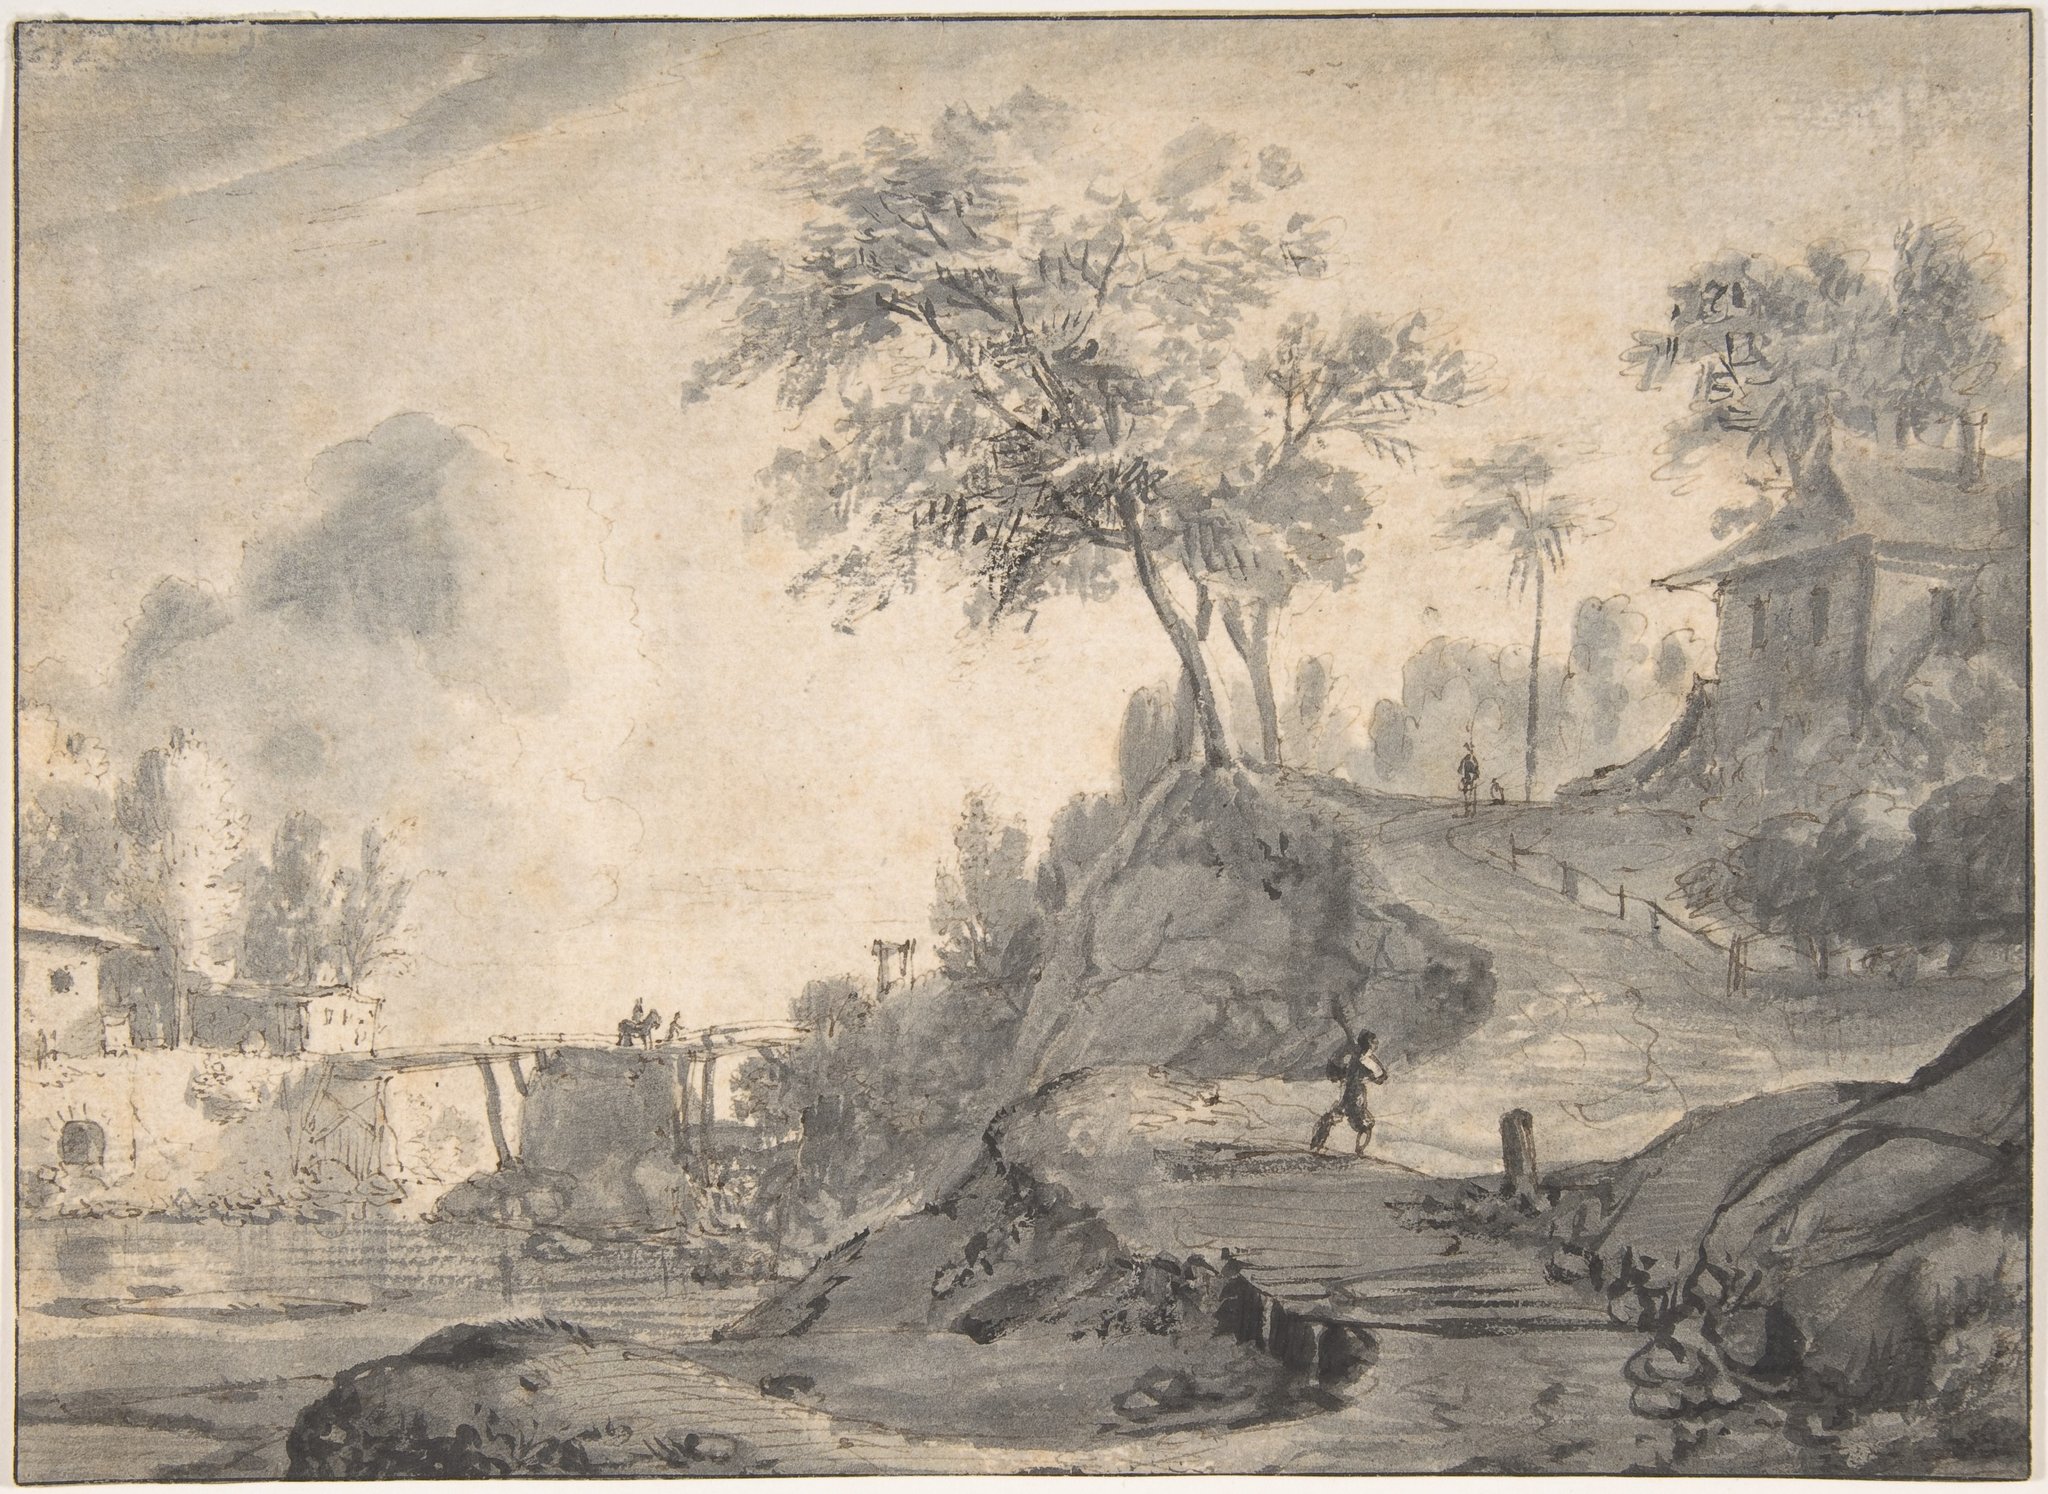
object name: drawing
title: Landscape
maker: roelant roghman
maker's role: artist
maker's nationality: dutch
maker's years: 1627-1692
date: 1601-1700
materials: ink, paper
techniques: brush, pen, wash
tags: bridges,landscapes